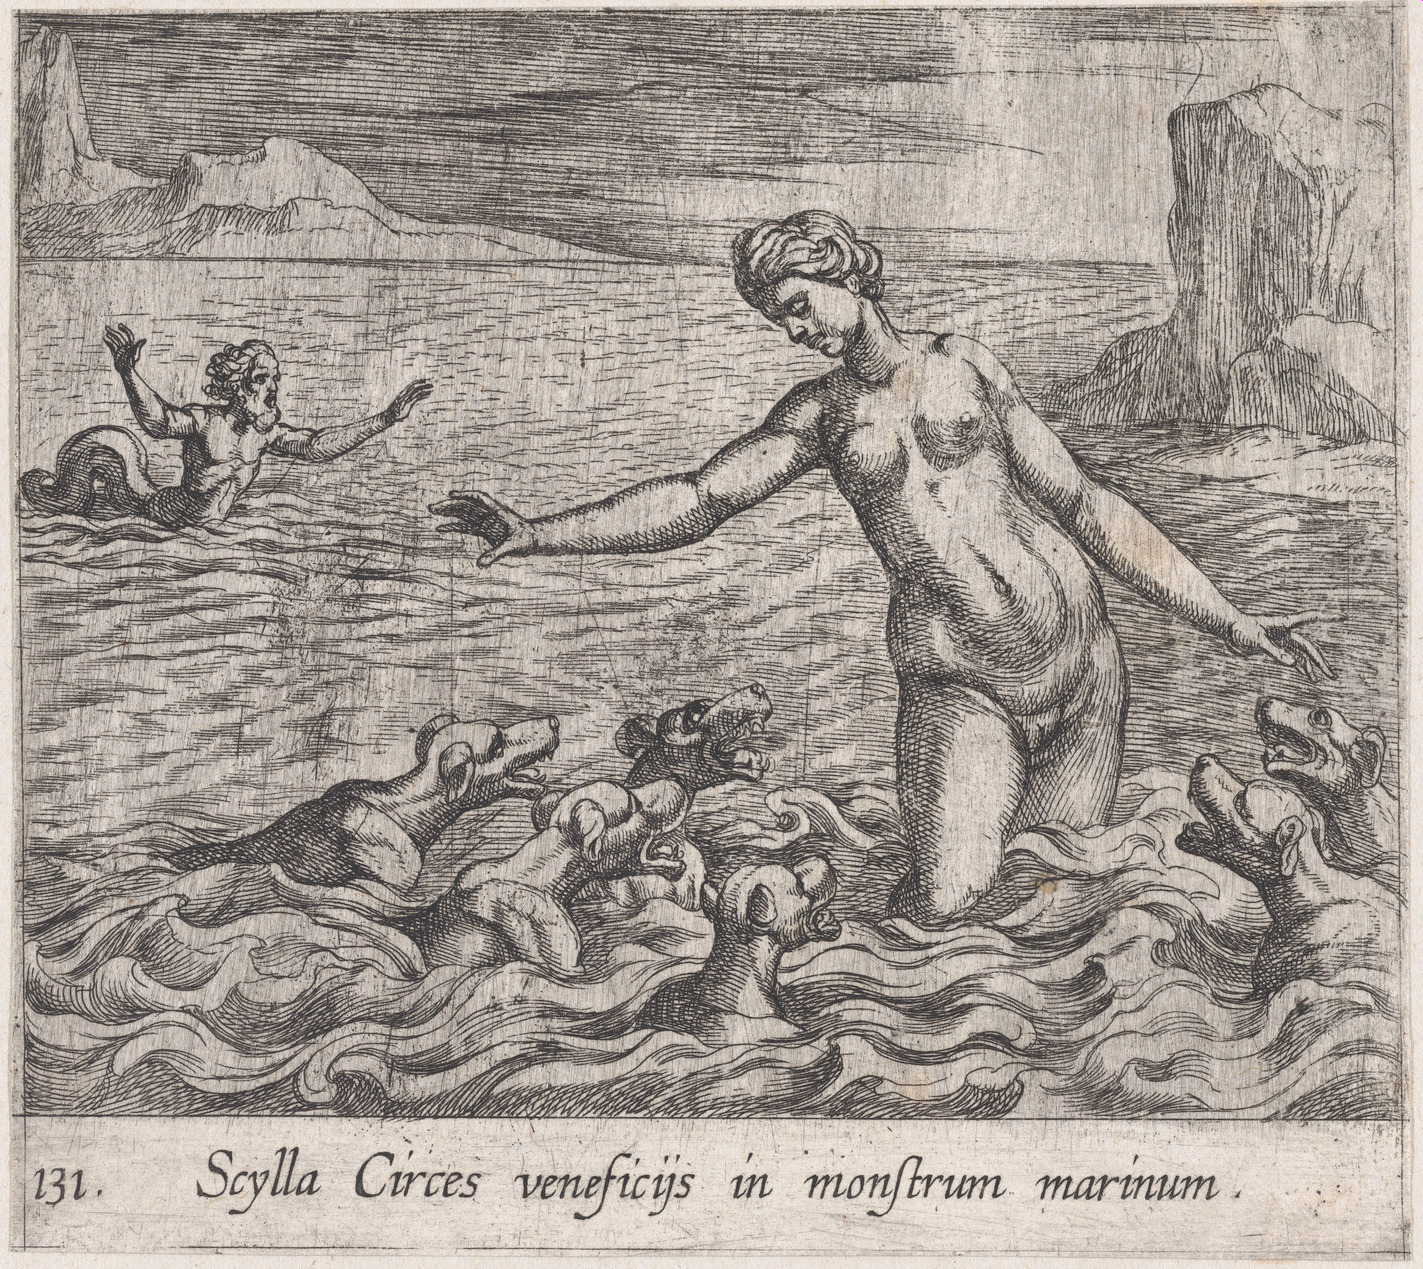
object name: print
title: Plate 131: Scylla Changed by Circe's Spell (Scylla Circes veneficÿs in monstrum marinum), from Ovid's 'Metamorphoses'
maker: antonio tempesta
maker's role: artist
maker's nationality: italian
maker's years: 1555-1630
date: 1606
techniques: etching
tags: men,female nudes